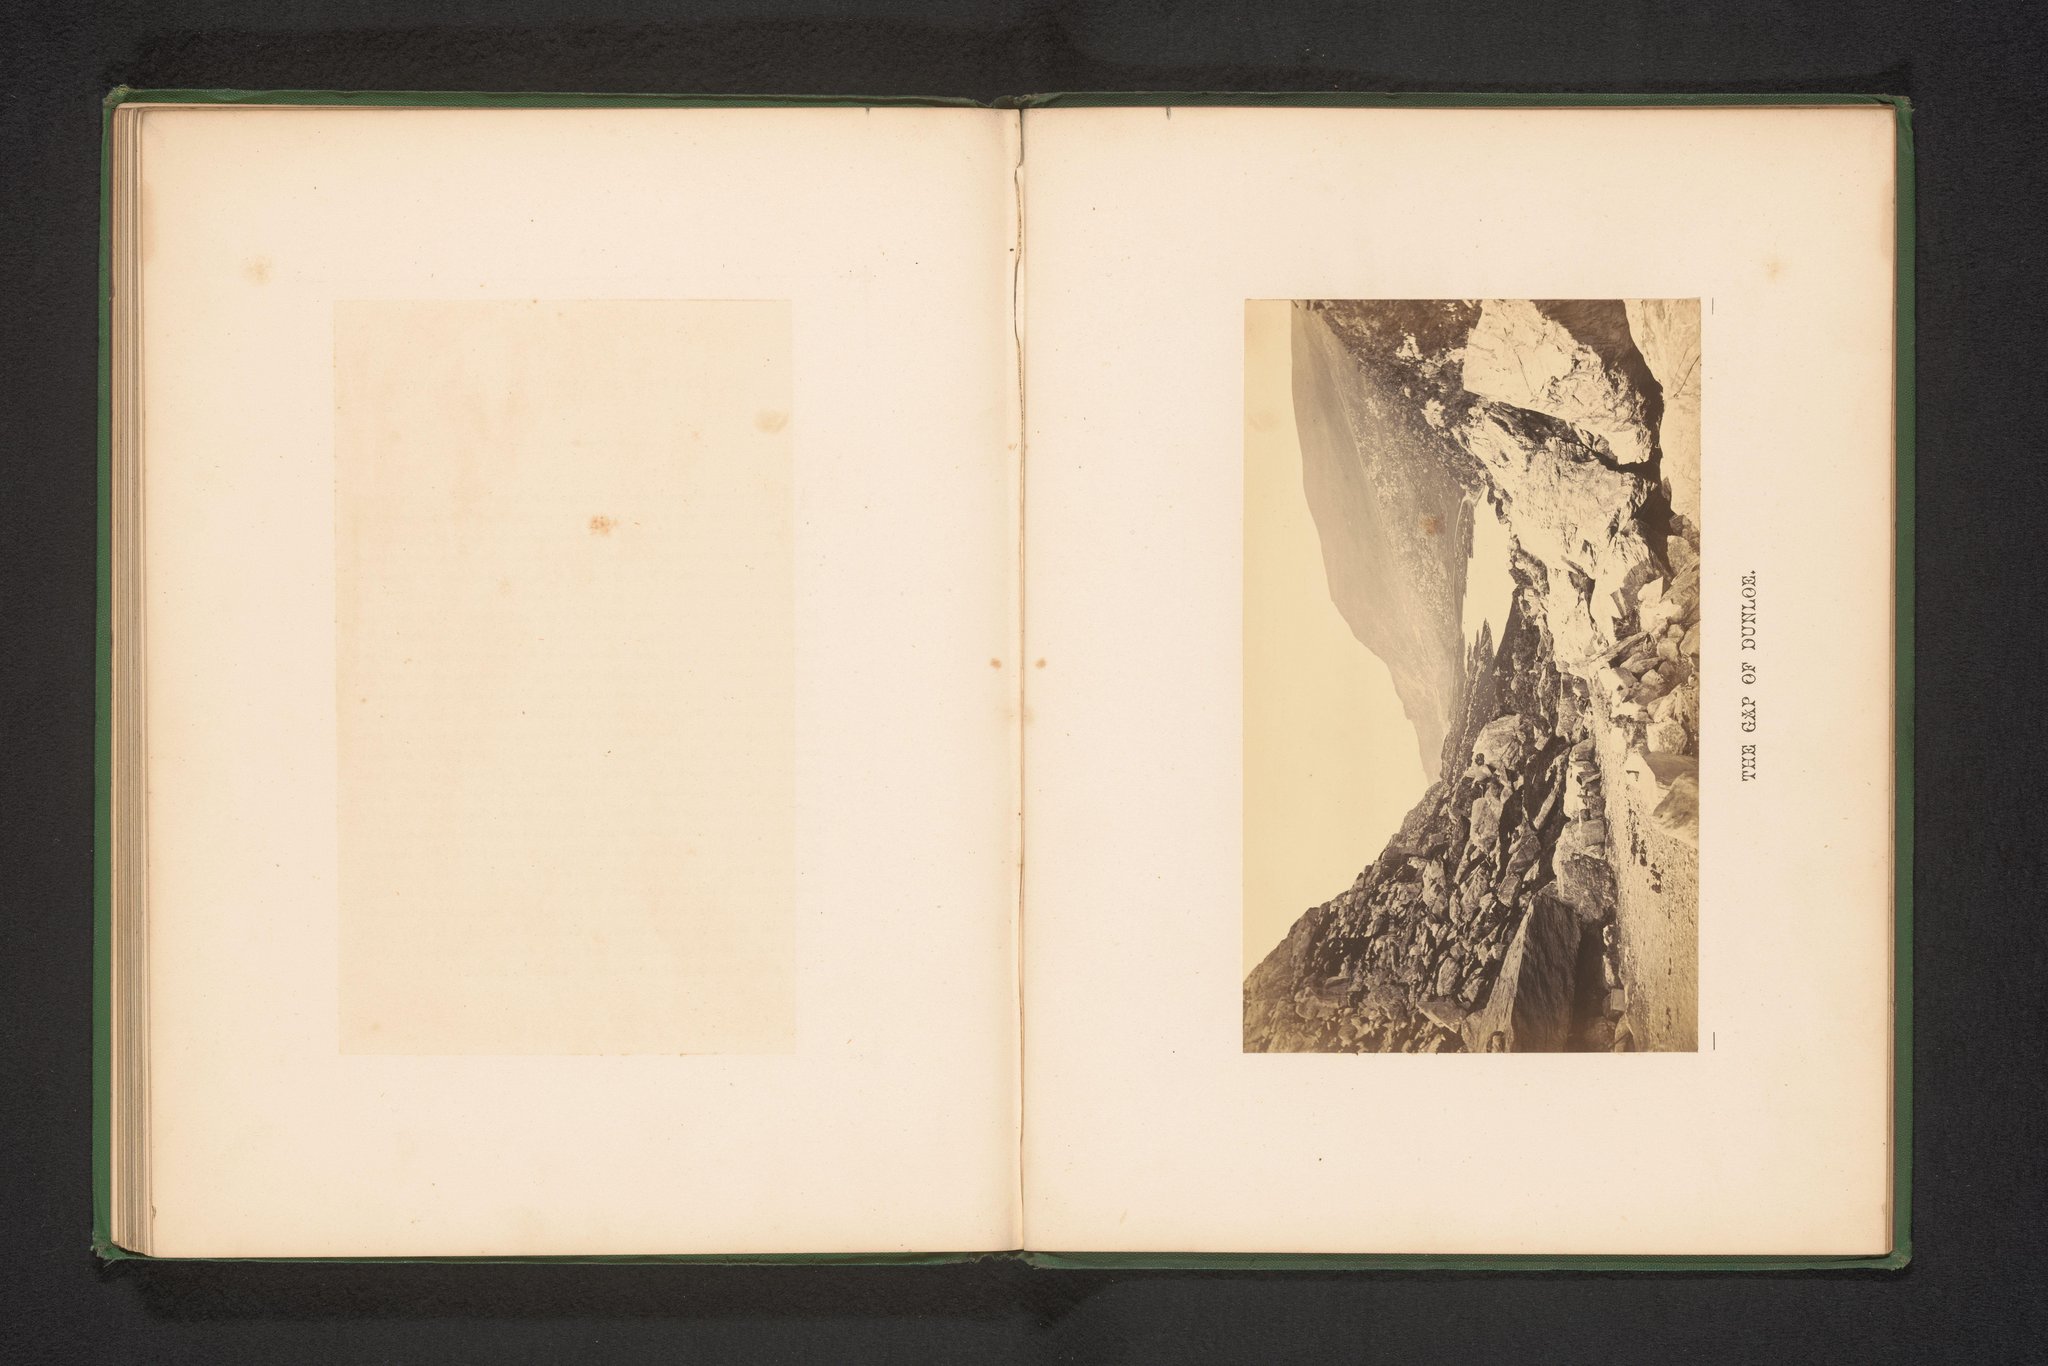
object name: photograph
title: The Gap of Dunloe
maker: john hudson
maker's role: fotograaf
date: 1862-1867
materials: photographic support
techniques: albumen print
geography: killarney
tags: landscapes with waters, waterscapes, seascapes (in the temperate zone), mountains